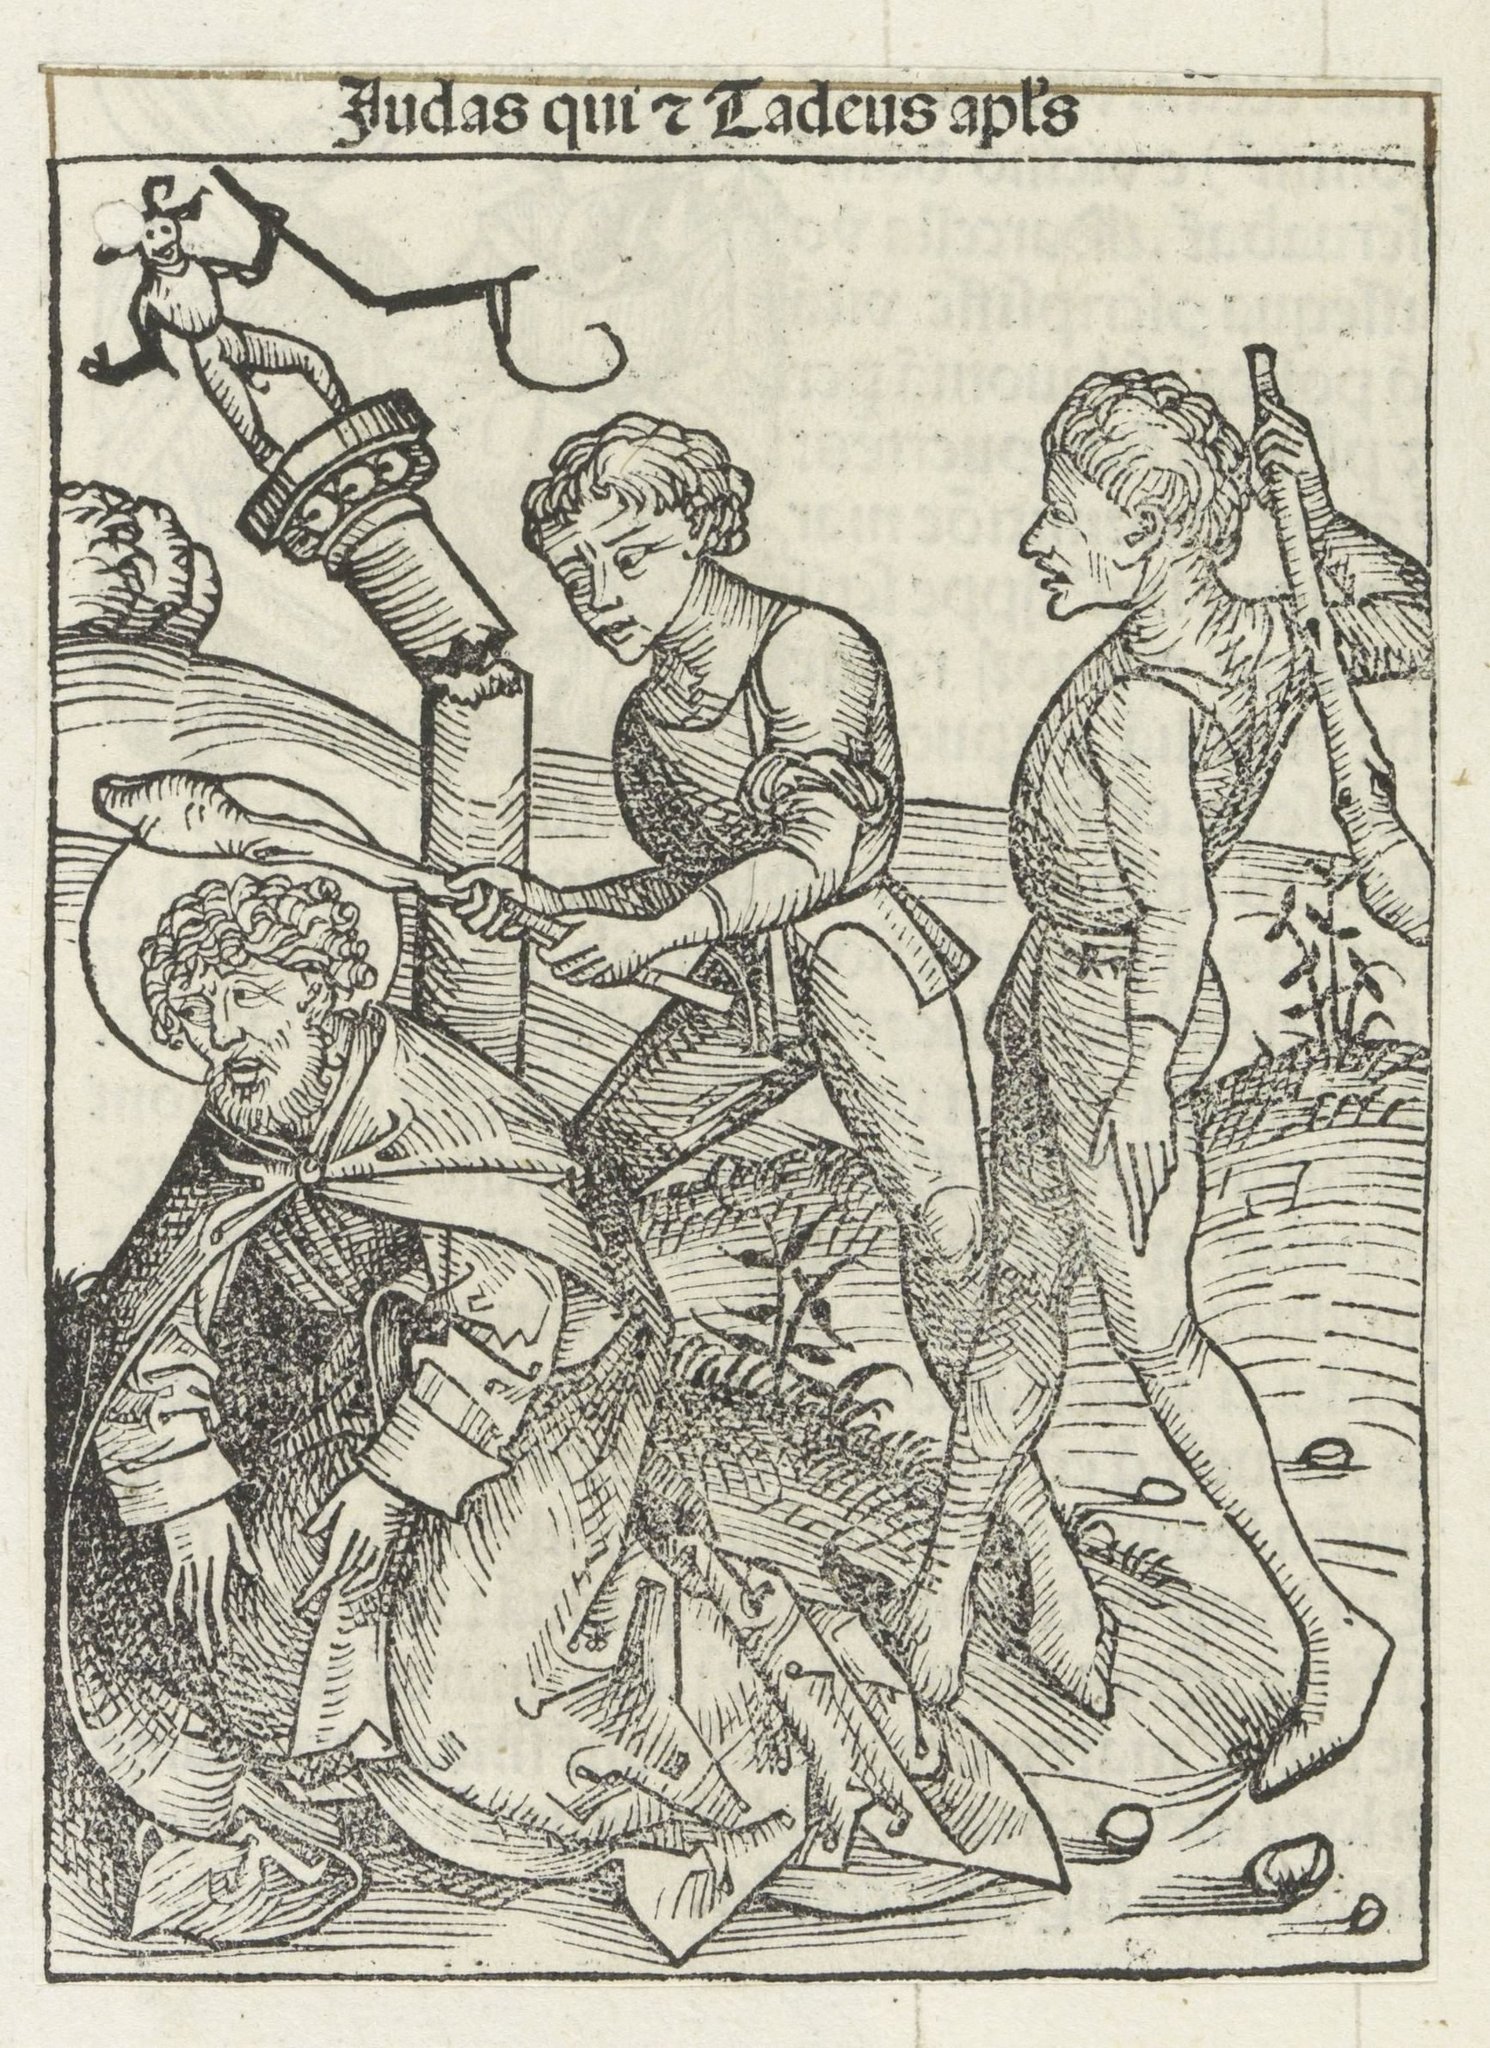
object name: book illustration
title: Judas qui [et] Tadeus ap[osto]l[u]s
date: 1493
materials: paper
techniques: letterpress printing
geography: nuremberg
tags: martyrdom and death of judas thaddaeus: he is beaten to death and beheaded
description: De houtsnede wordt gebruikt als boekillustratie in de Liber Chronicarum (of Neurenbergkroniek) van Hartmann Schedel, verschenen in het Latijn en Duits in 1493. Zie de Latijnse uitgave, folio 107r.